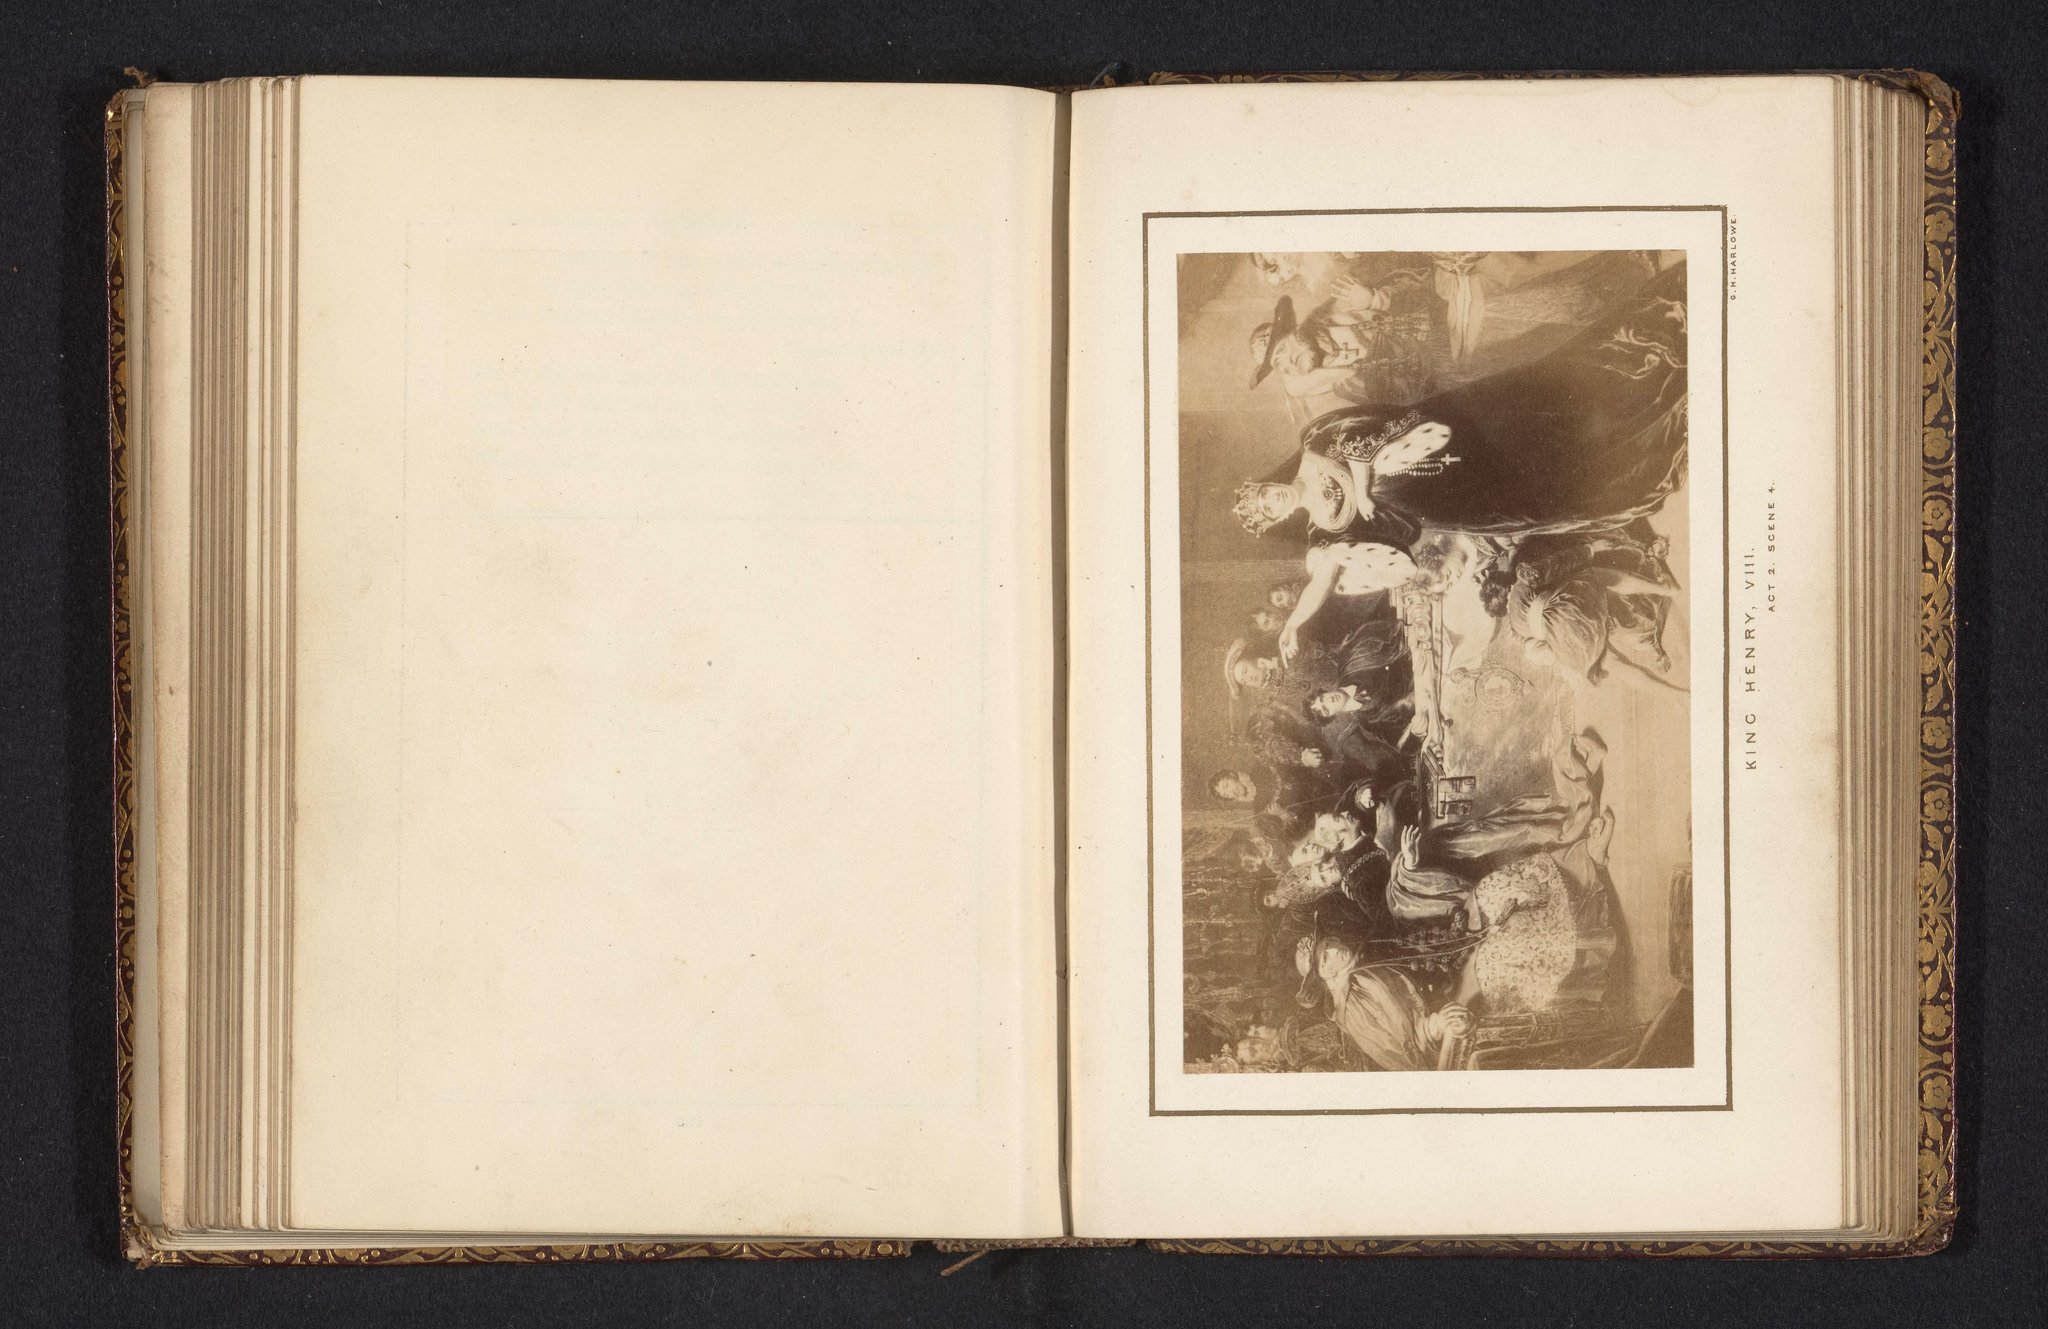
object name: reproduction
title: King Henry VIII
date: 1866-1876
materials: photographic support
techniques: albumen print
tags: cardinal, ruler, sovereign - bb - female ruler, ruler, sovereign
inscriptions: inscription: ‘Act 2, scene 4.’